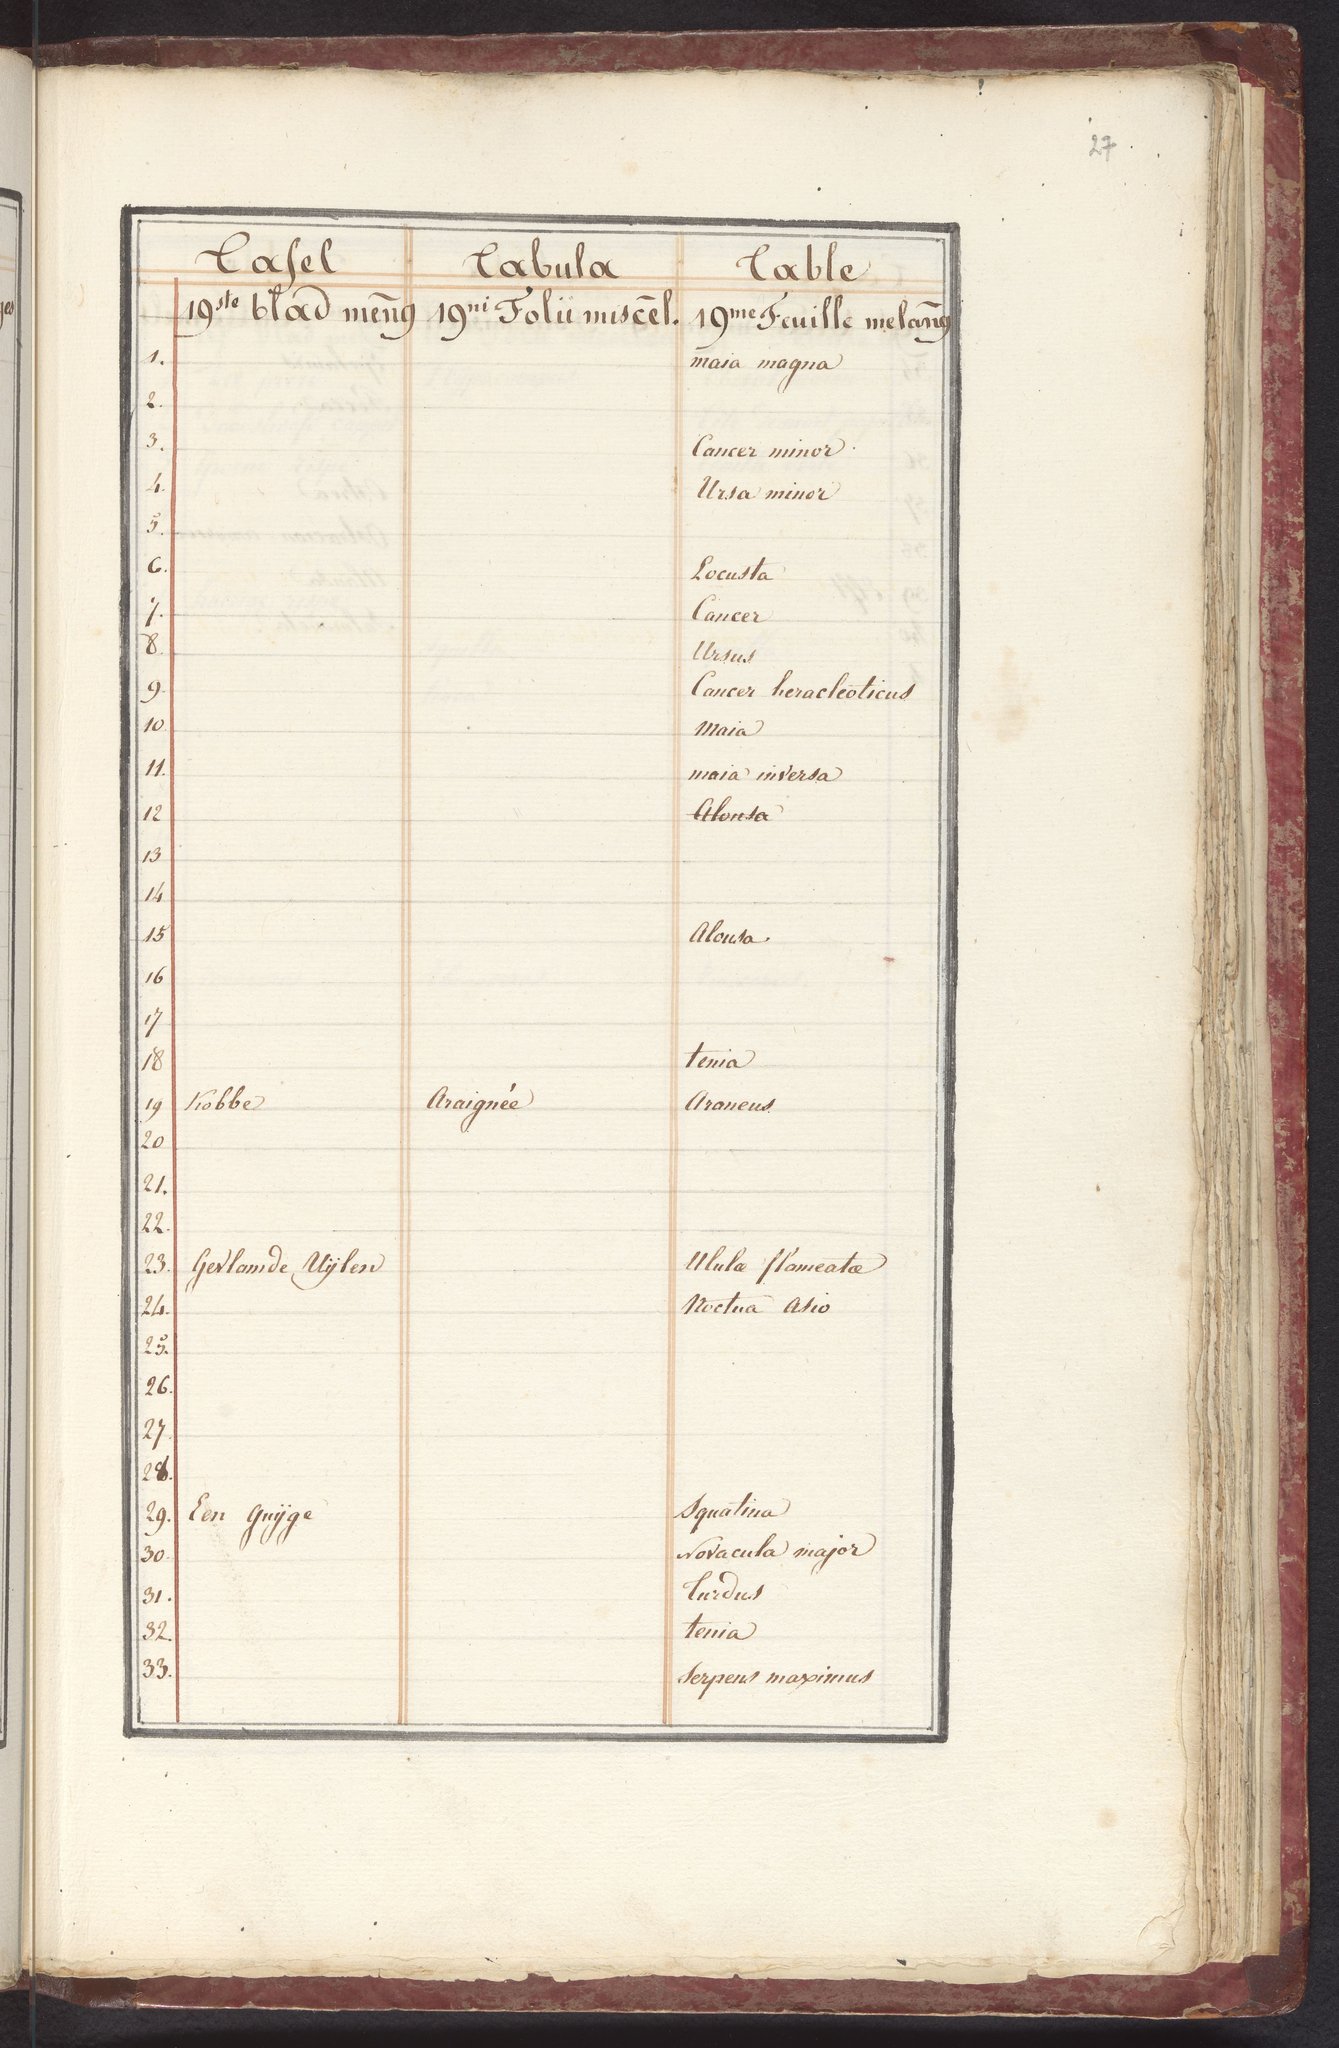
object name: manuscript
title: Lijst van dieren en planten in het negentiende ensemble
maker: joseph van huerne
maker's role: kunstliefhebber, mecenas, verzamelaar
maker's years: 1752-1844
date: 1809-1814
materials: ink, paper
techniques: handwriting, pen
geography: bruges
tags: handwriting, written text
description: Schema met een lijst in drie kolommen van de dieren en planten afgebeeld in het negentiende ensemble, nummers 1-33. Onderdeel van het zevende album met tekeningen van reptielen, amfibieën en natuurhistorische ensembles. Het zevende van twaalf albums met aquarellen van dieren, vogels en planten bekend rond 1600, gemaakt in opdracht van keizer Rudolf II. Met toelichting in Nederlands, Latijn en Frans.